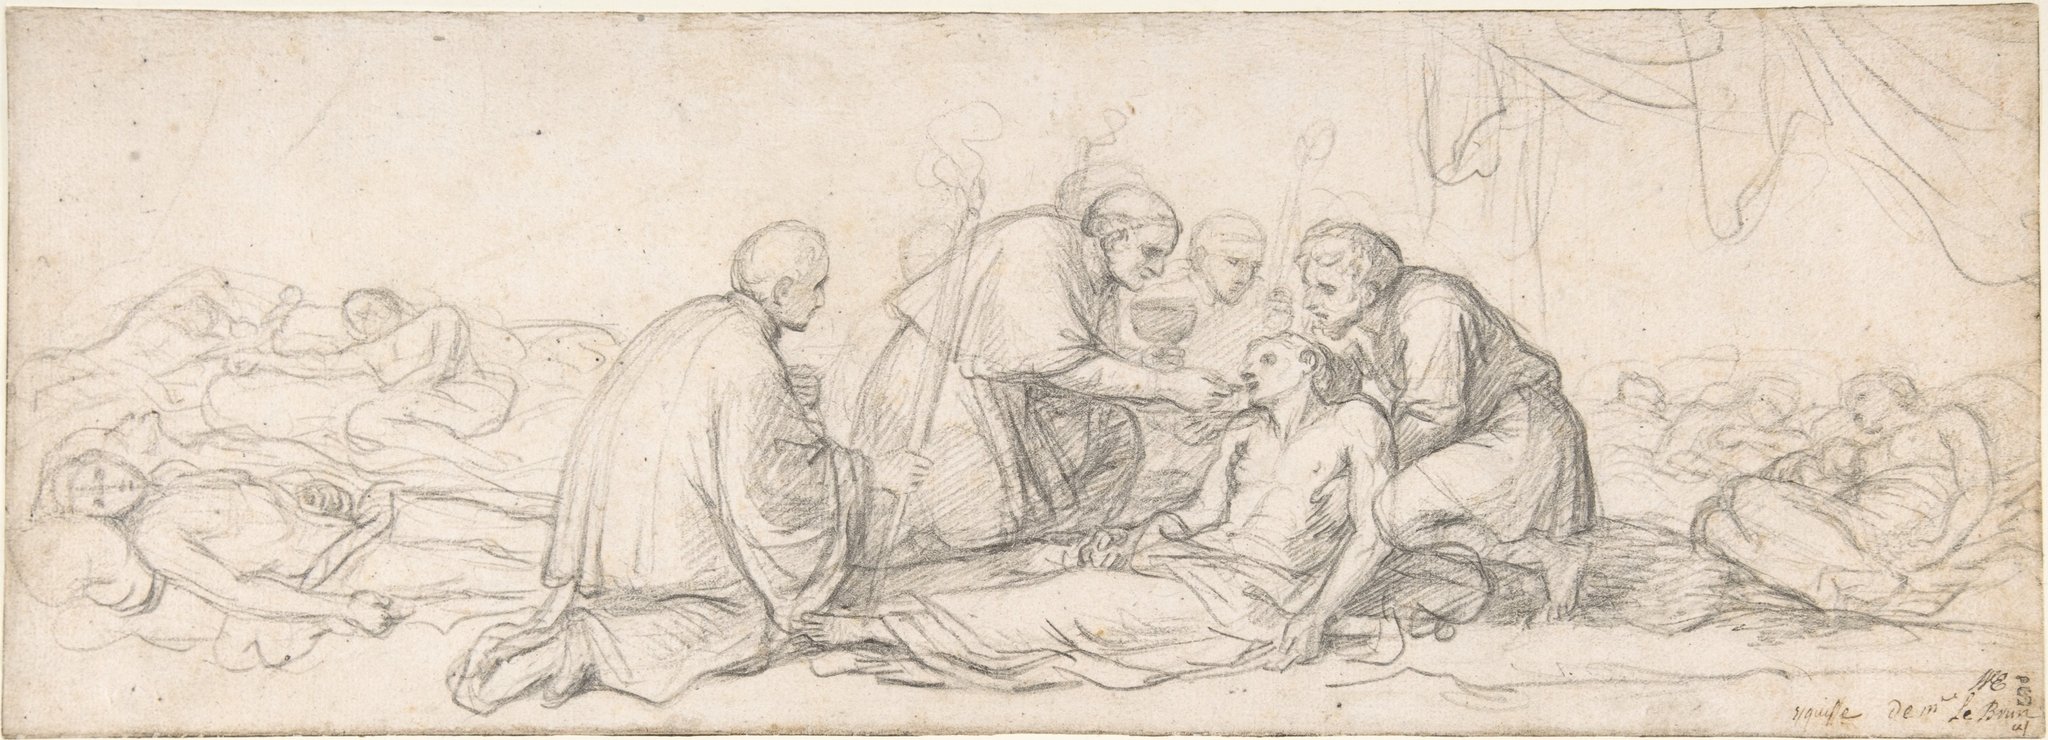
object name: drawing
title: St. Charles Borromeo Giving Communion to the Plague-Stricken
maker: charles le brun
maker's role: artist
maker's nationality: french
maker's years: 1619-1690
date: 1601-1700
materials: chalk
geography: france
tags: suffering,men,saints